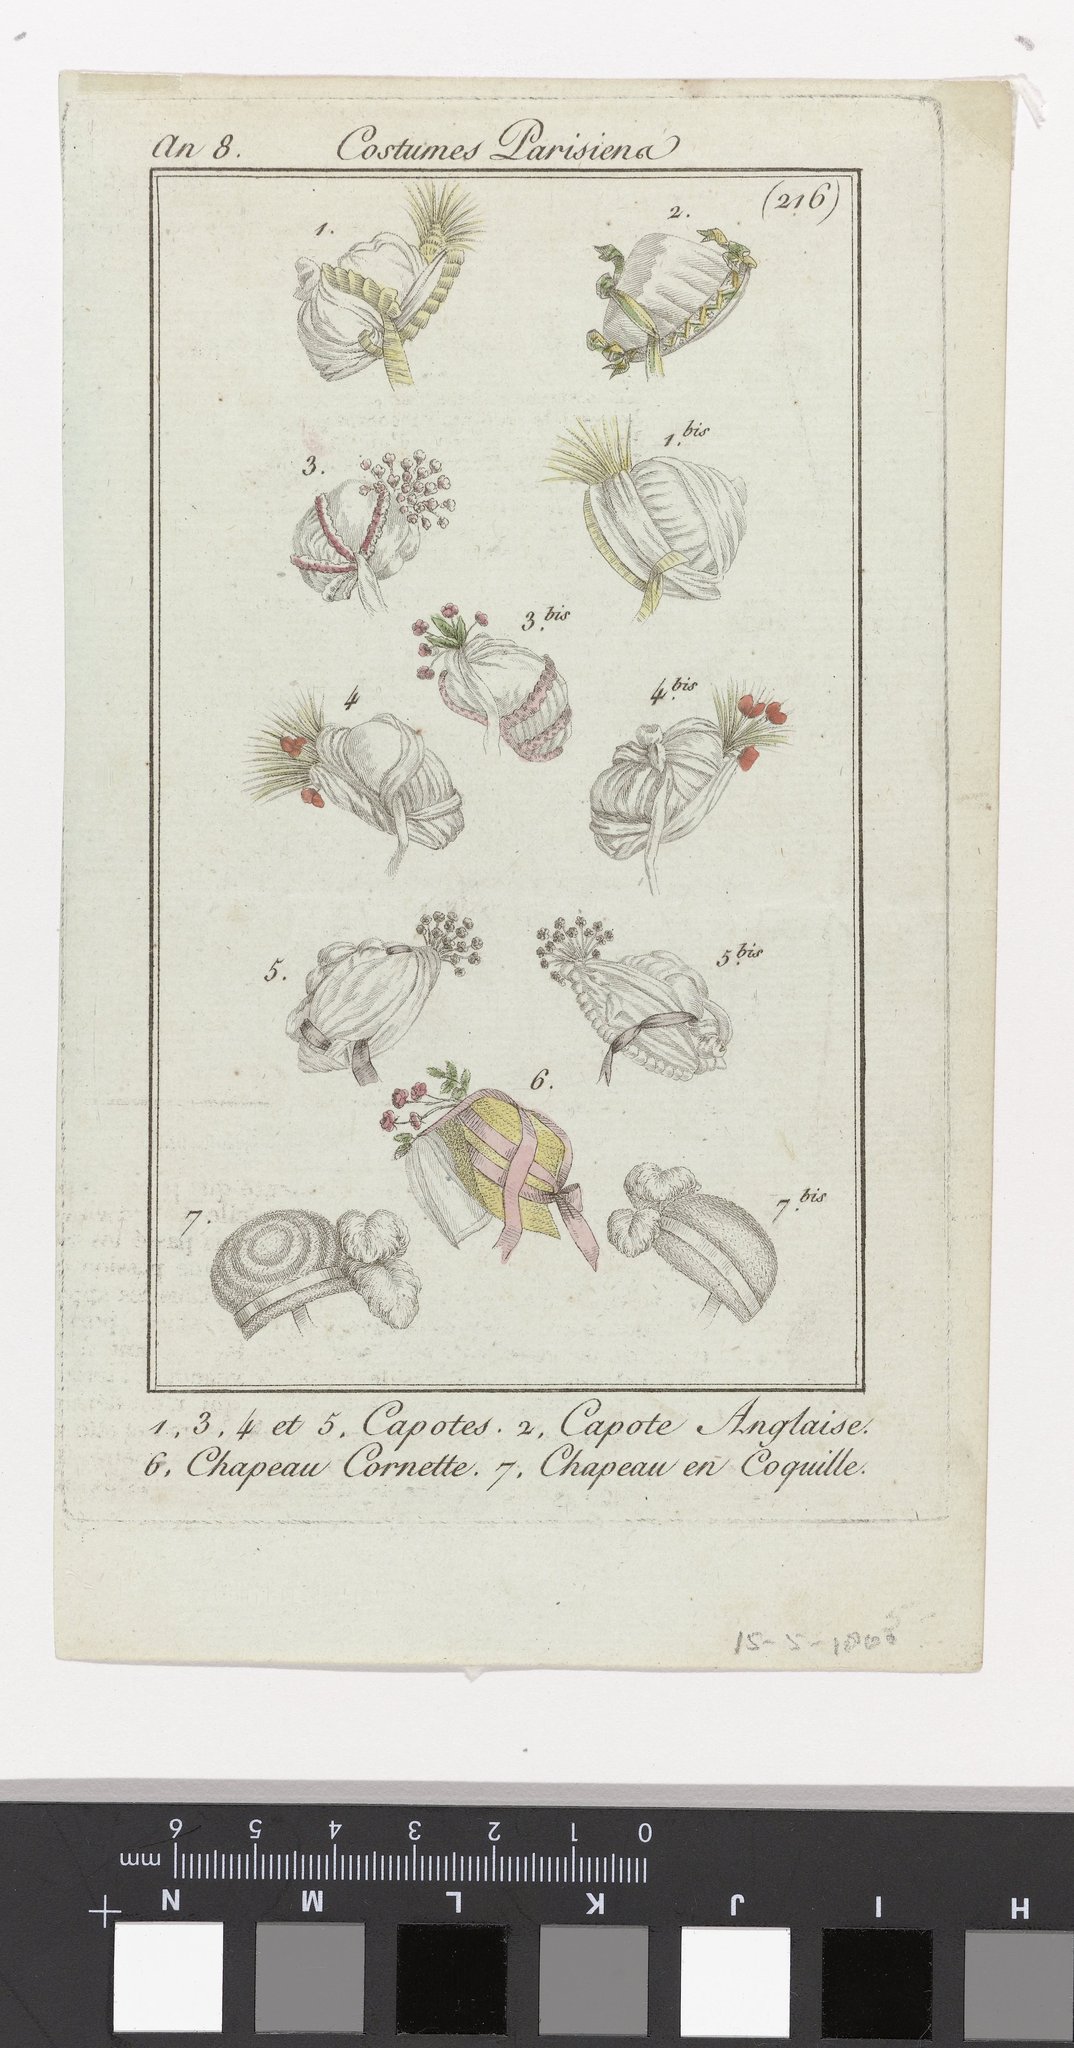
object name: fashion print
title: Journal des Dames et des Modes, Costume Parisien, 15 mai 1800, An 8, (216) : 1, 3, 4 et 5, Capotes (...)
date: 1800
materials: paper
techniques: engraving, hand coloring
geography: paris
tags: head-gear (capote) (+ women's clothes), head-gear (cornette) (+ women's clothes), fashion plates, head-gear: hat (+ women's clothes)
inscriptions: caption: ‘1,3,4 et 5. Capotes.2, Capote Anglaise.6, Chapeau Cornette,7. Chapeau en Coquille.’, title: ‘Costumes Parisiens.’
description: Zeven verschillende vrouwenhoeden in één kader, genummerd één tot en met zeven: 1,3,4 en 5: 'Capotes', 2: 'Capote Anglaise', 6: 'Chapeau Cornette', 7: 'Chapeau en Coquille'. De nummers 1,3,4,5 en 7 zijn verdubbeld met een bis nummer en zijn van weerszijden weergegeven. De prent maakt deel uit van het modetijdschrift Journal des Dames et des Modes, uitgegeven door Pierre de la Mésangère, Parijs, 1797-1839.